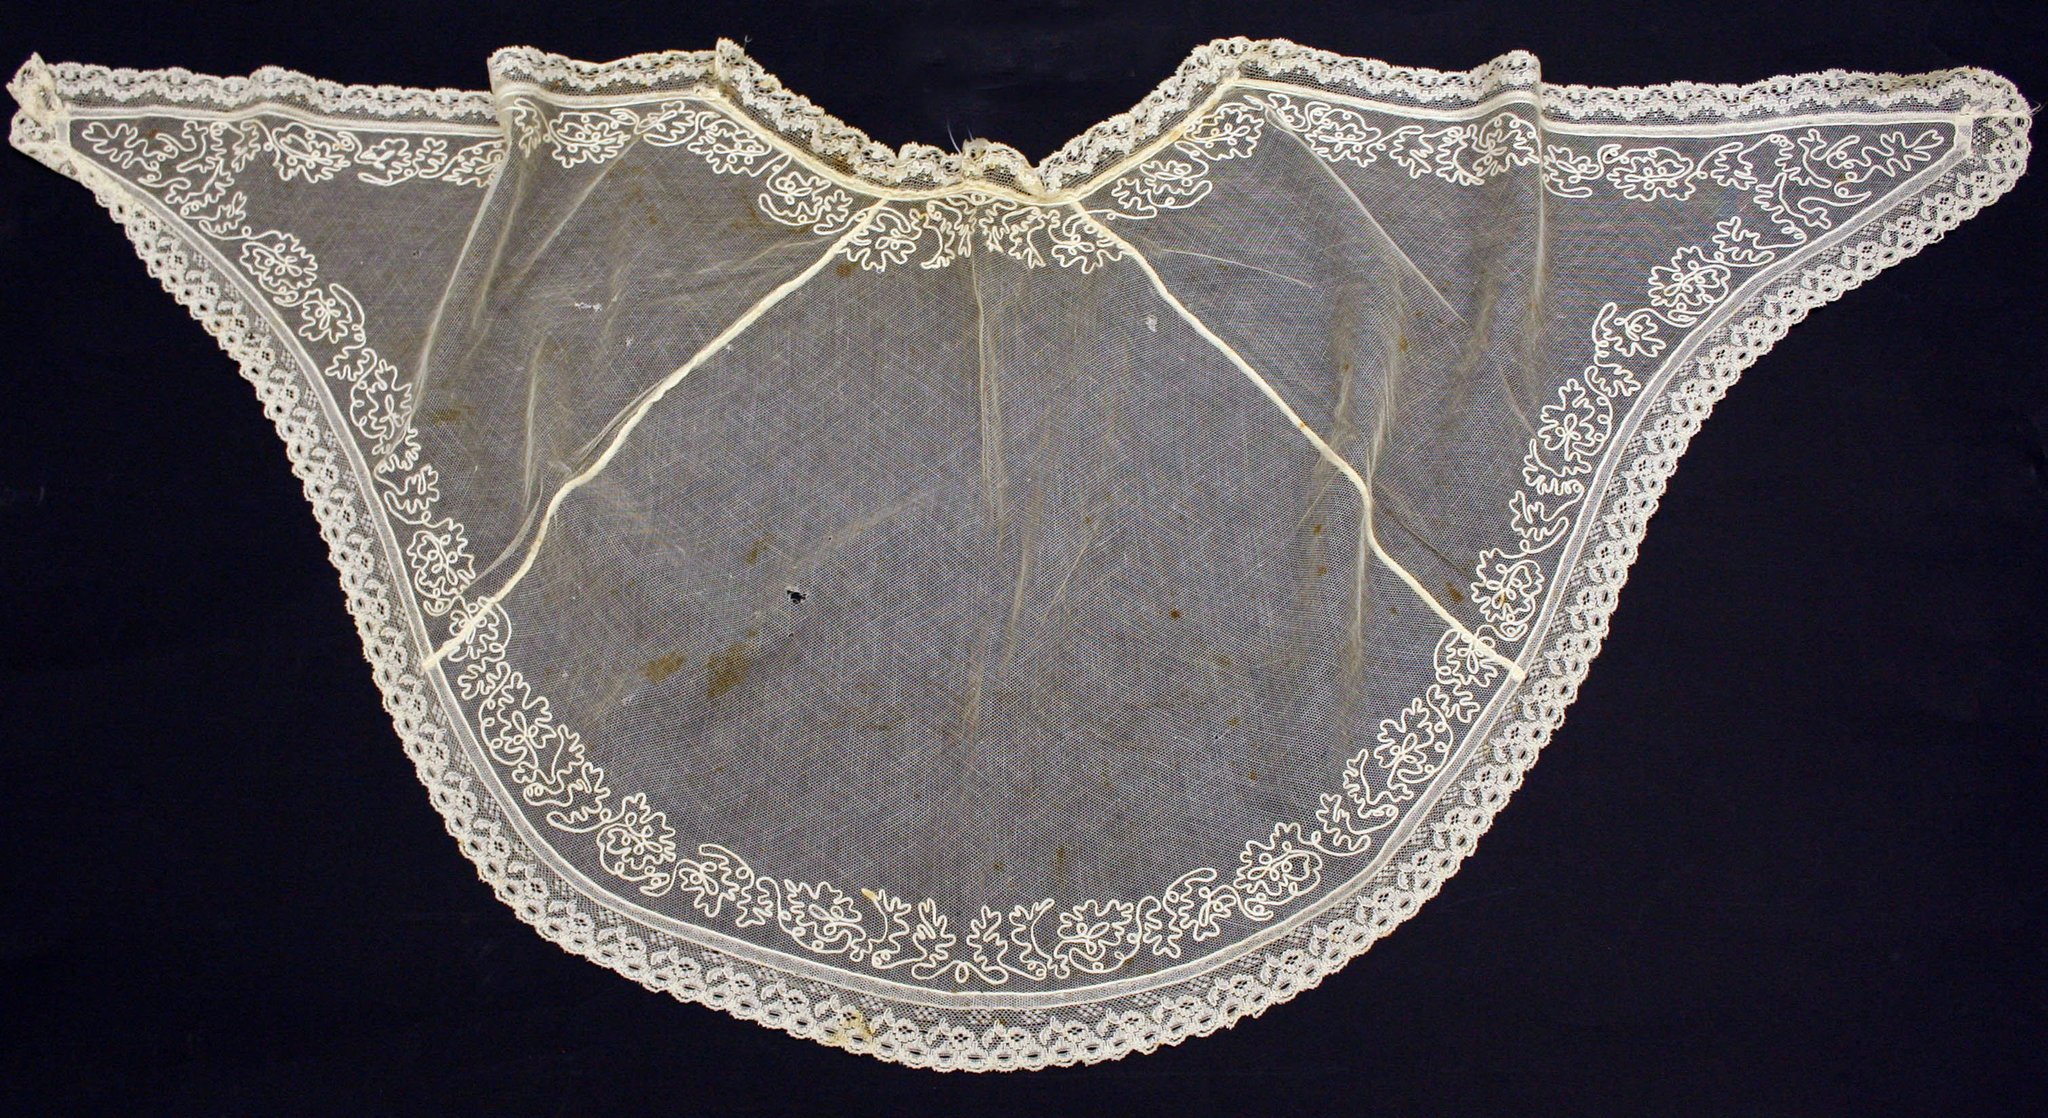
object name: collar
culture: american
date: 1860-1869